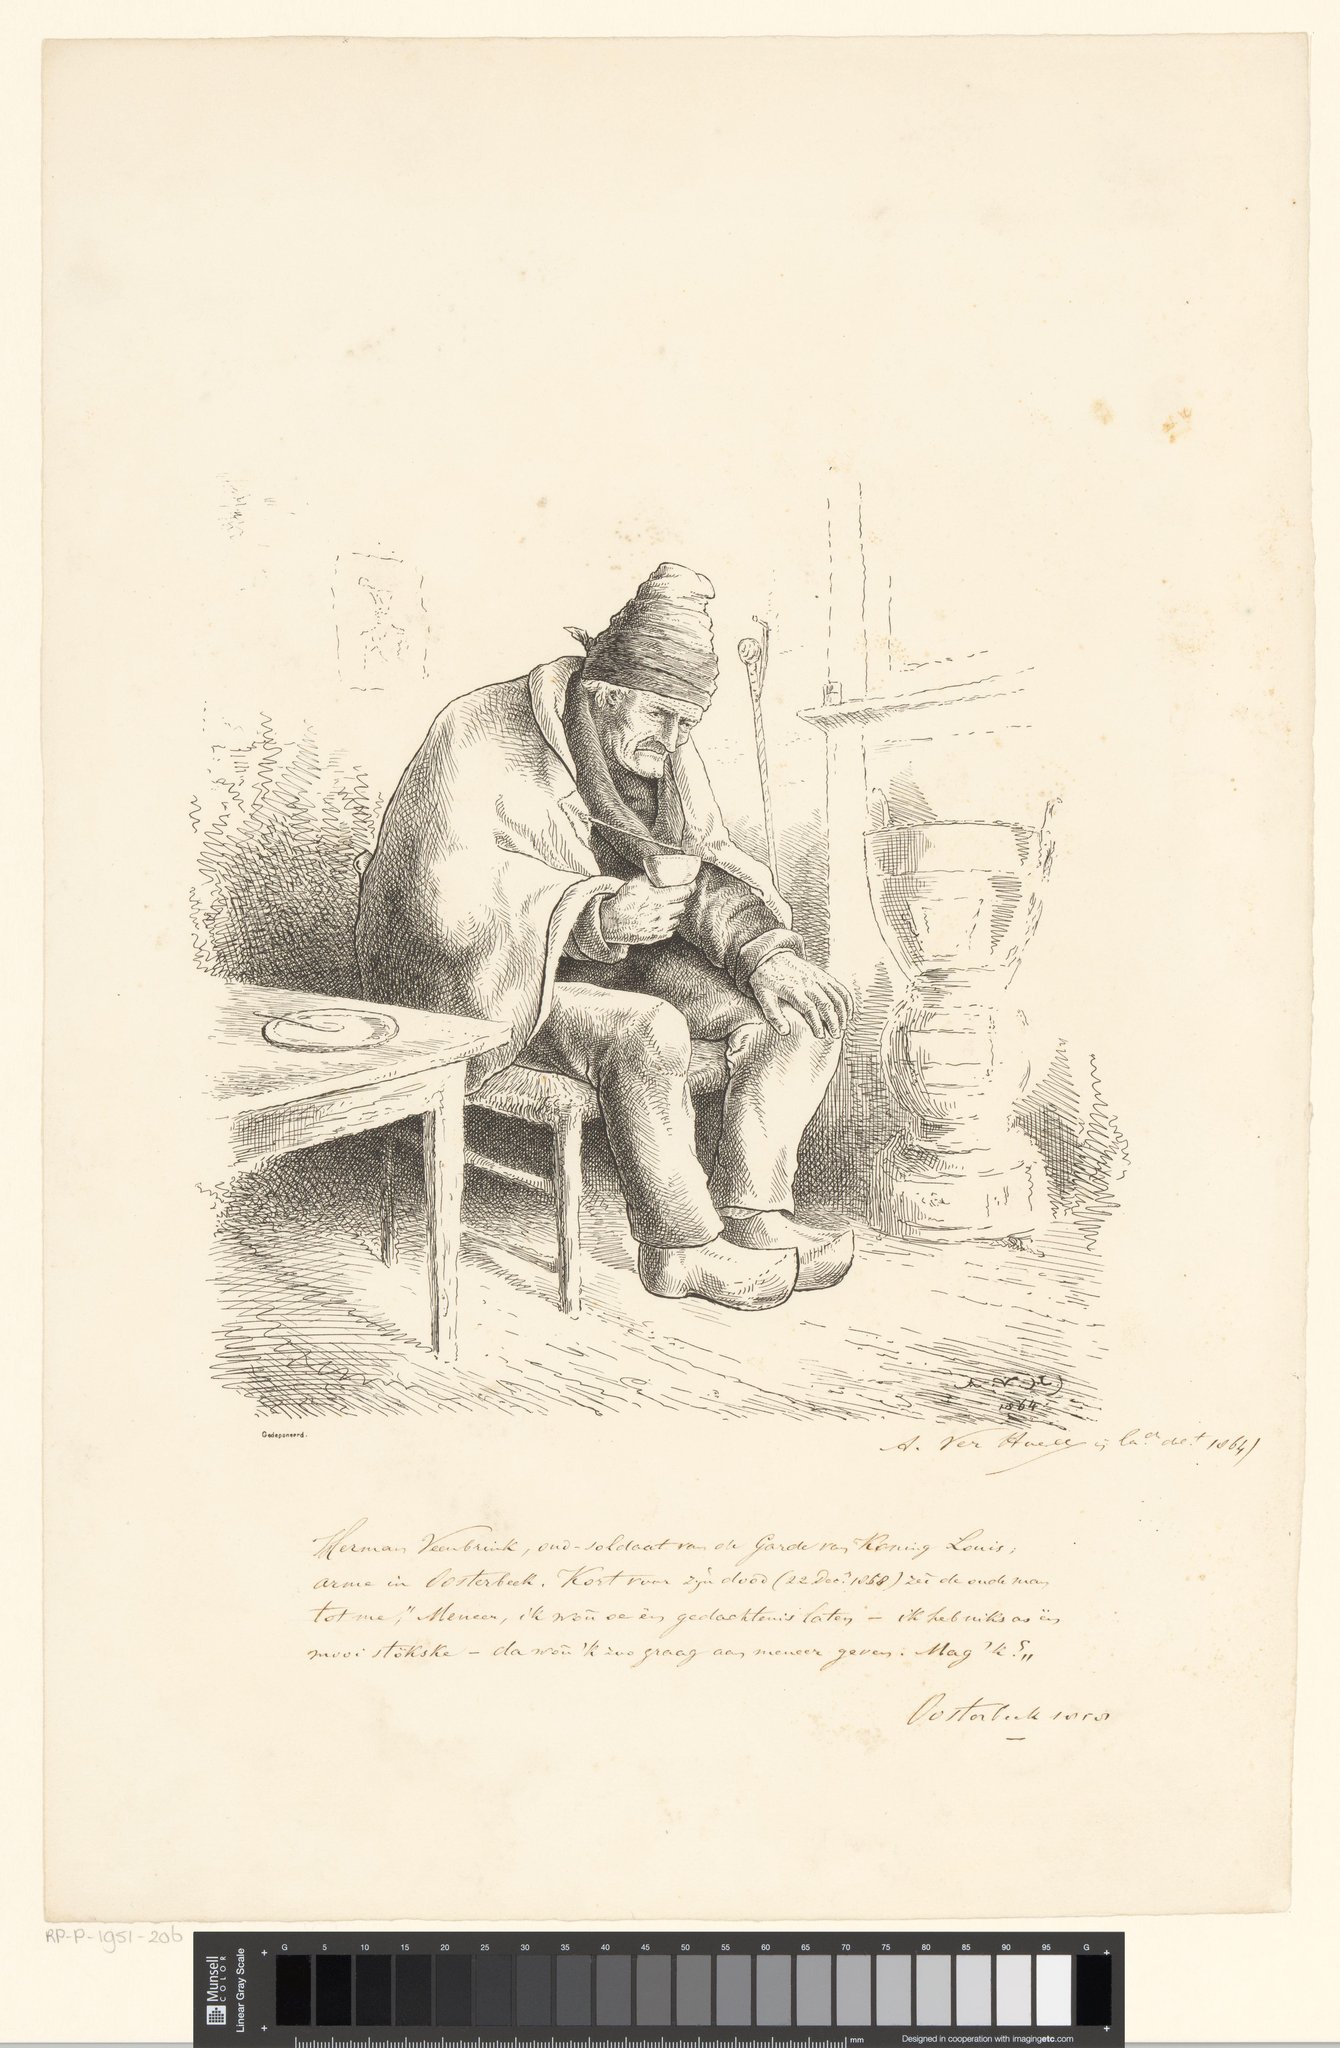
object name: print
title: Oude man op stoel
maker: alexander ver huell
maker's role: draughtsman, print maker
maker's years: 1822-1897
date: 1864-1866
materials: paper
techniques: lithograph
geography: arnhem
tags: old man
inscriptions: collector's mark: Lugt 2228, : ‘Gedeponeerd.’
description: Een oude man, Herman Veenbrink, zit voorovergebogen op een stoel. In zijn hand houdt hij een beker.